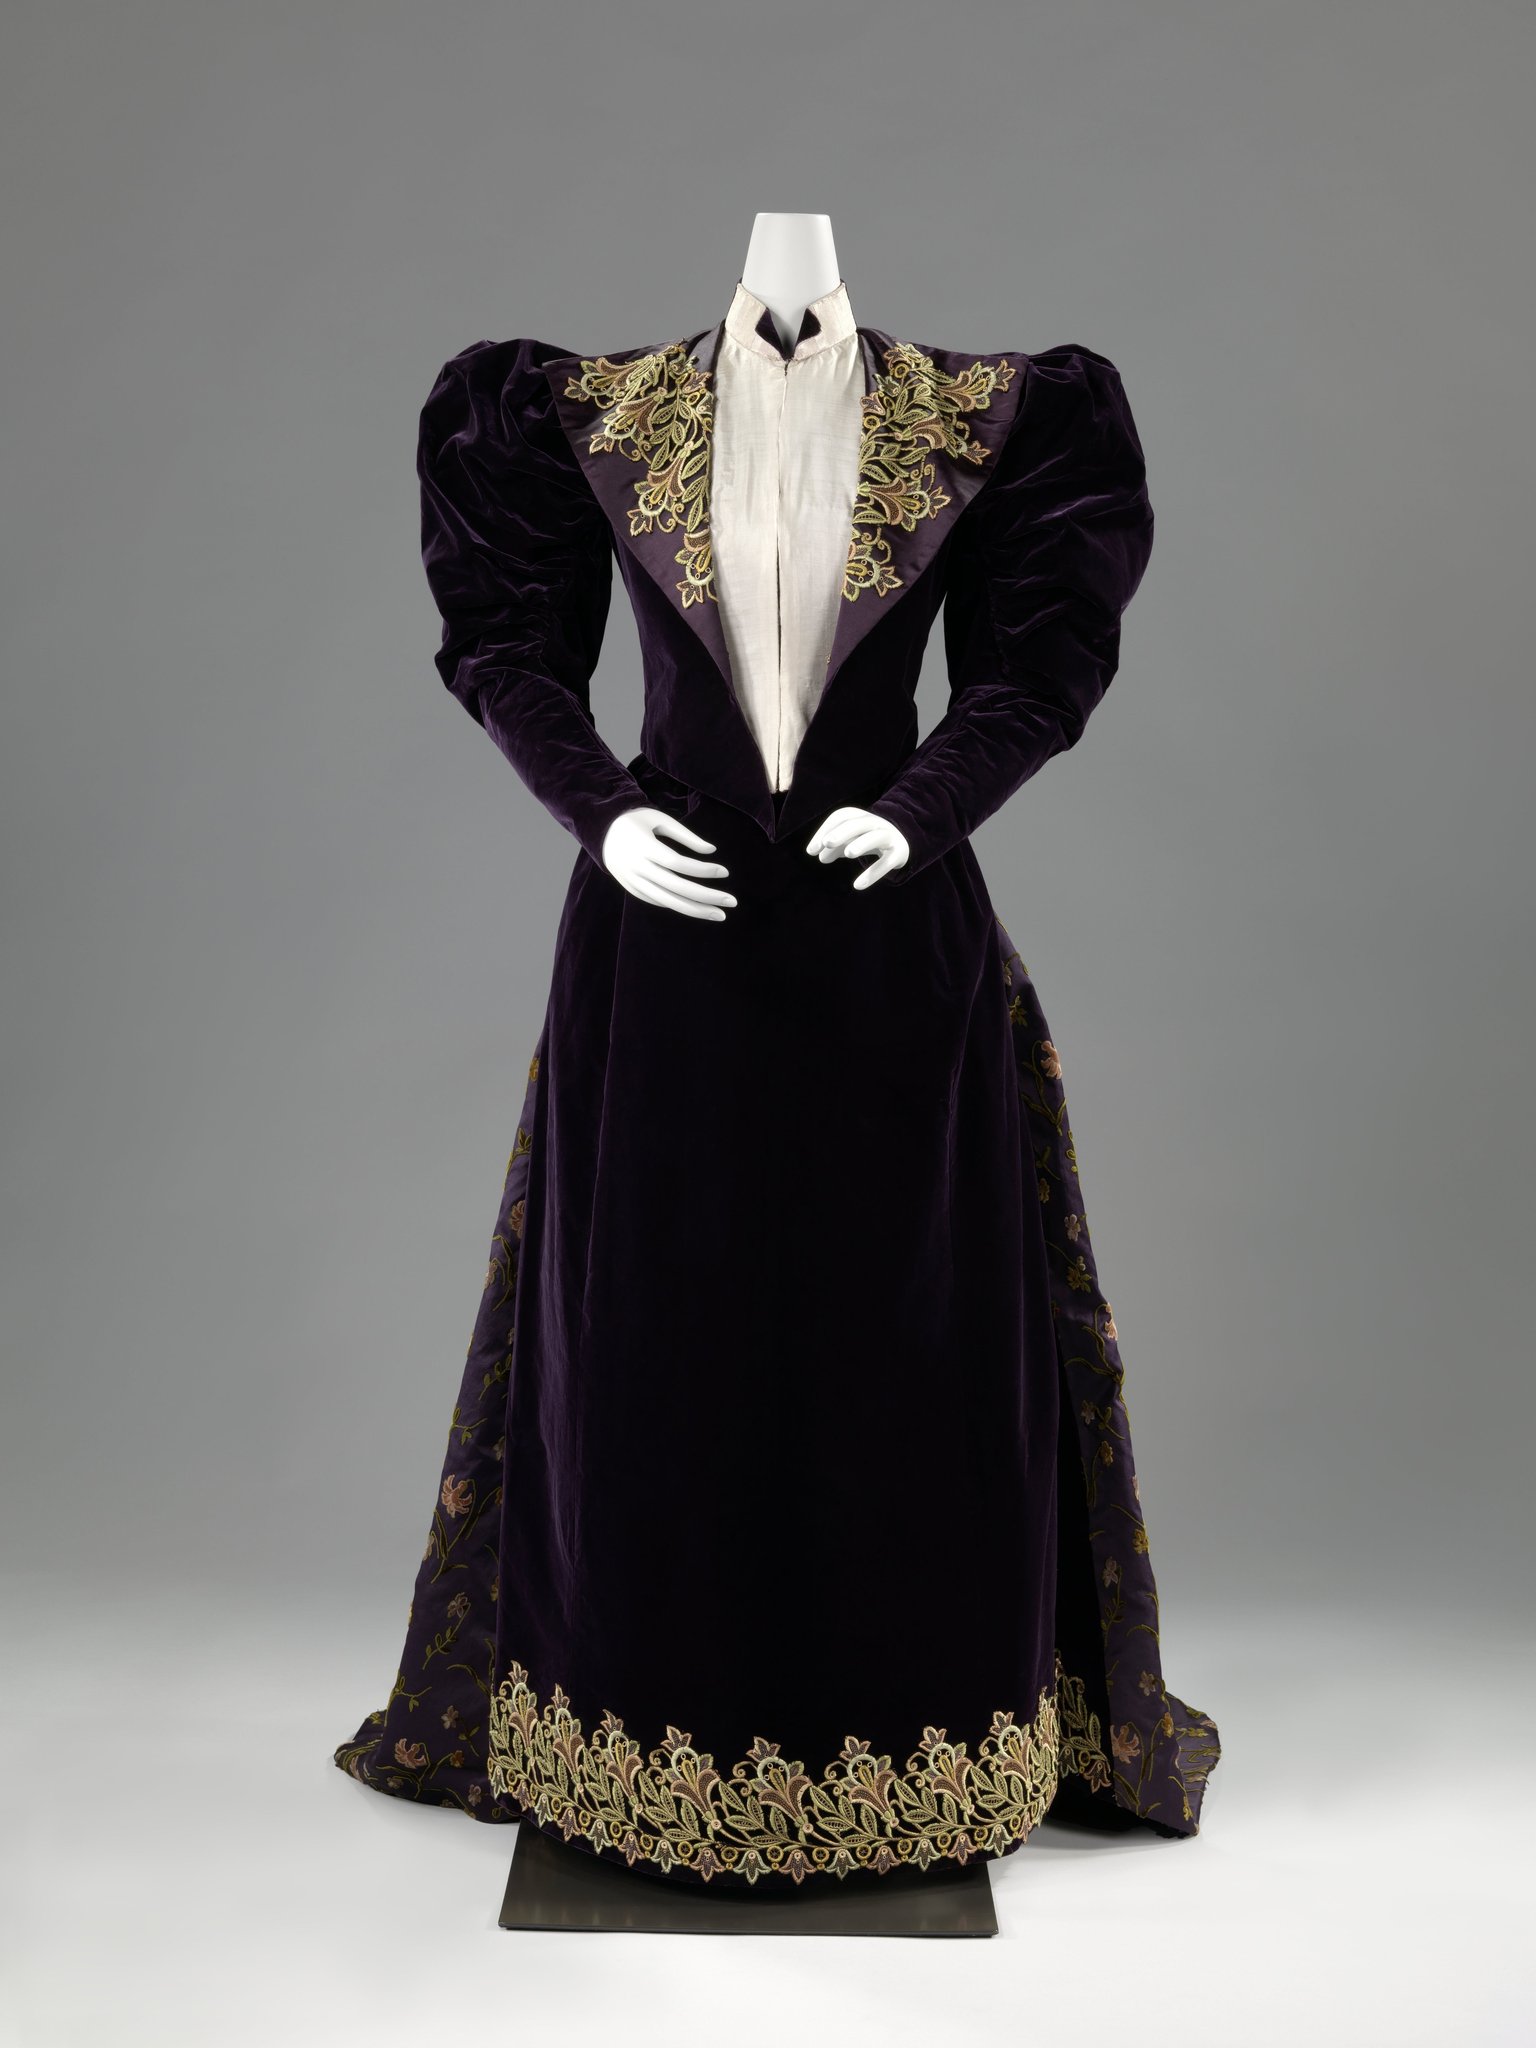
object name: skirt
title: Rok met queue en sleep van paars fluweel, versierd met veelkleurige florale applicaties.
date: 1893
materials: silk, velvet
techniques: appliqué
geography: amsterdam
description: Rok horend bij een japon van paars fluweel. Rok met fluwelen voorbanen; sleep en achterbanen van paarse zijde met opgeweven fluwelen bloemtakken. De voering is van paarse zijde en voorzien van drie stroken.